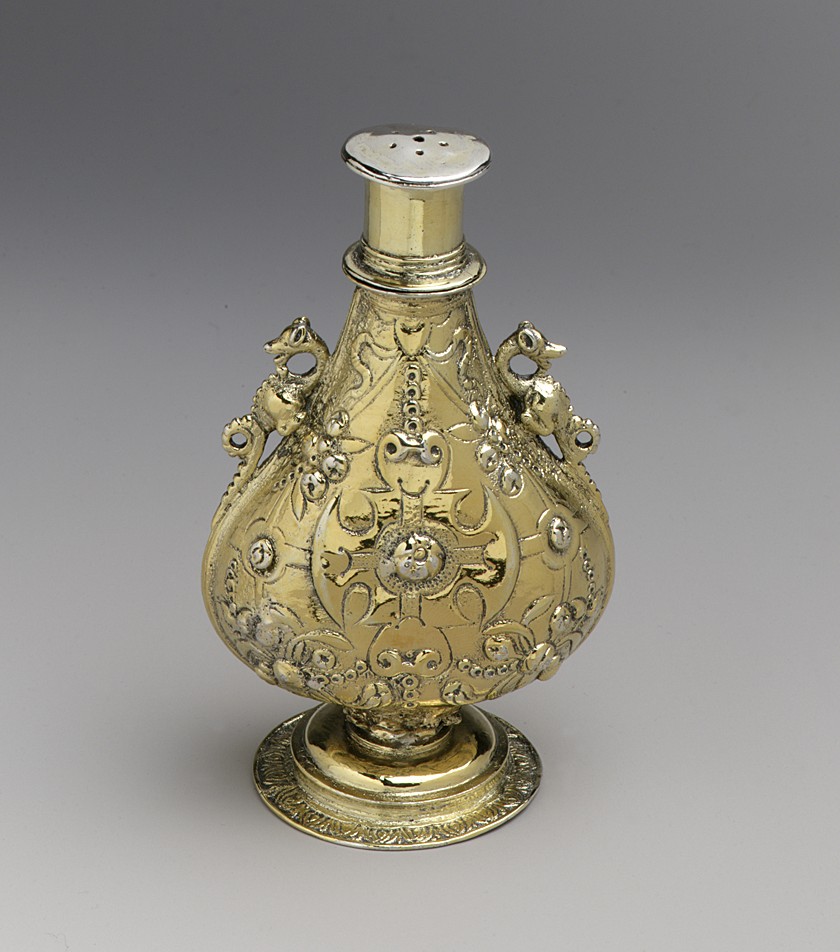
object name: perfume bottle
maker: jasper fysher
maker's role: maker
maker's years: 1568-1585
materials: silver gilt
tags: dragons